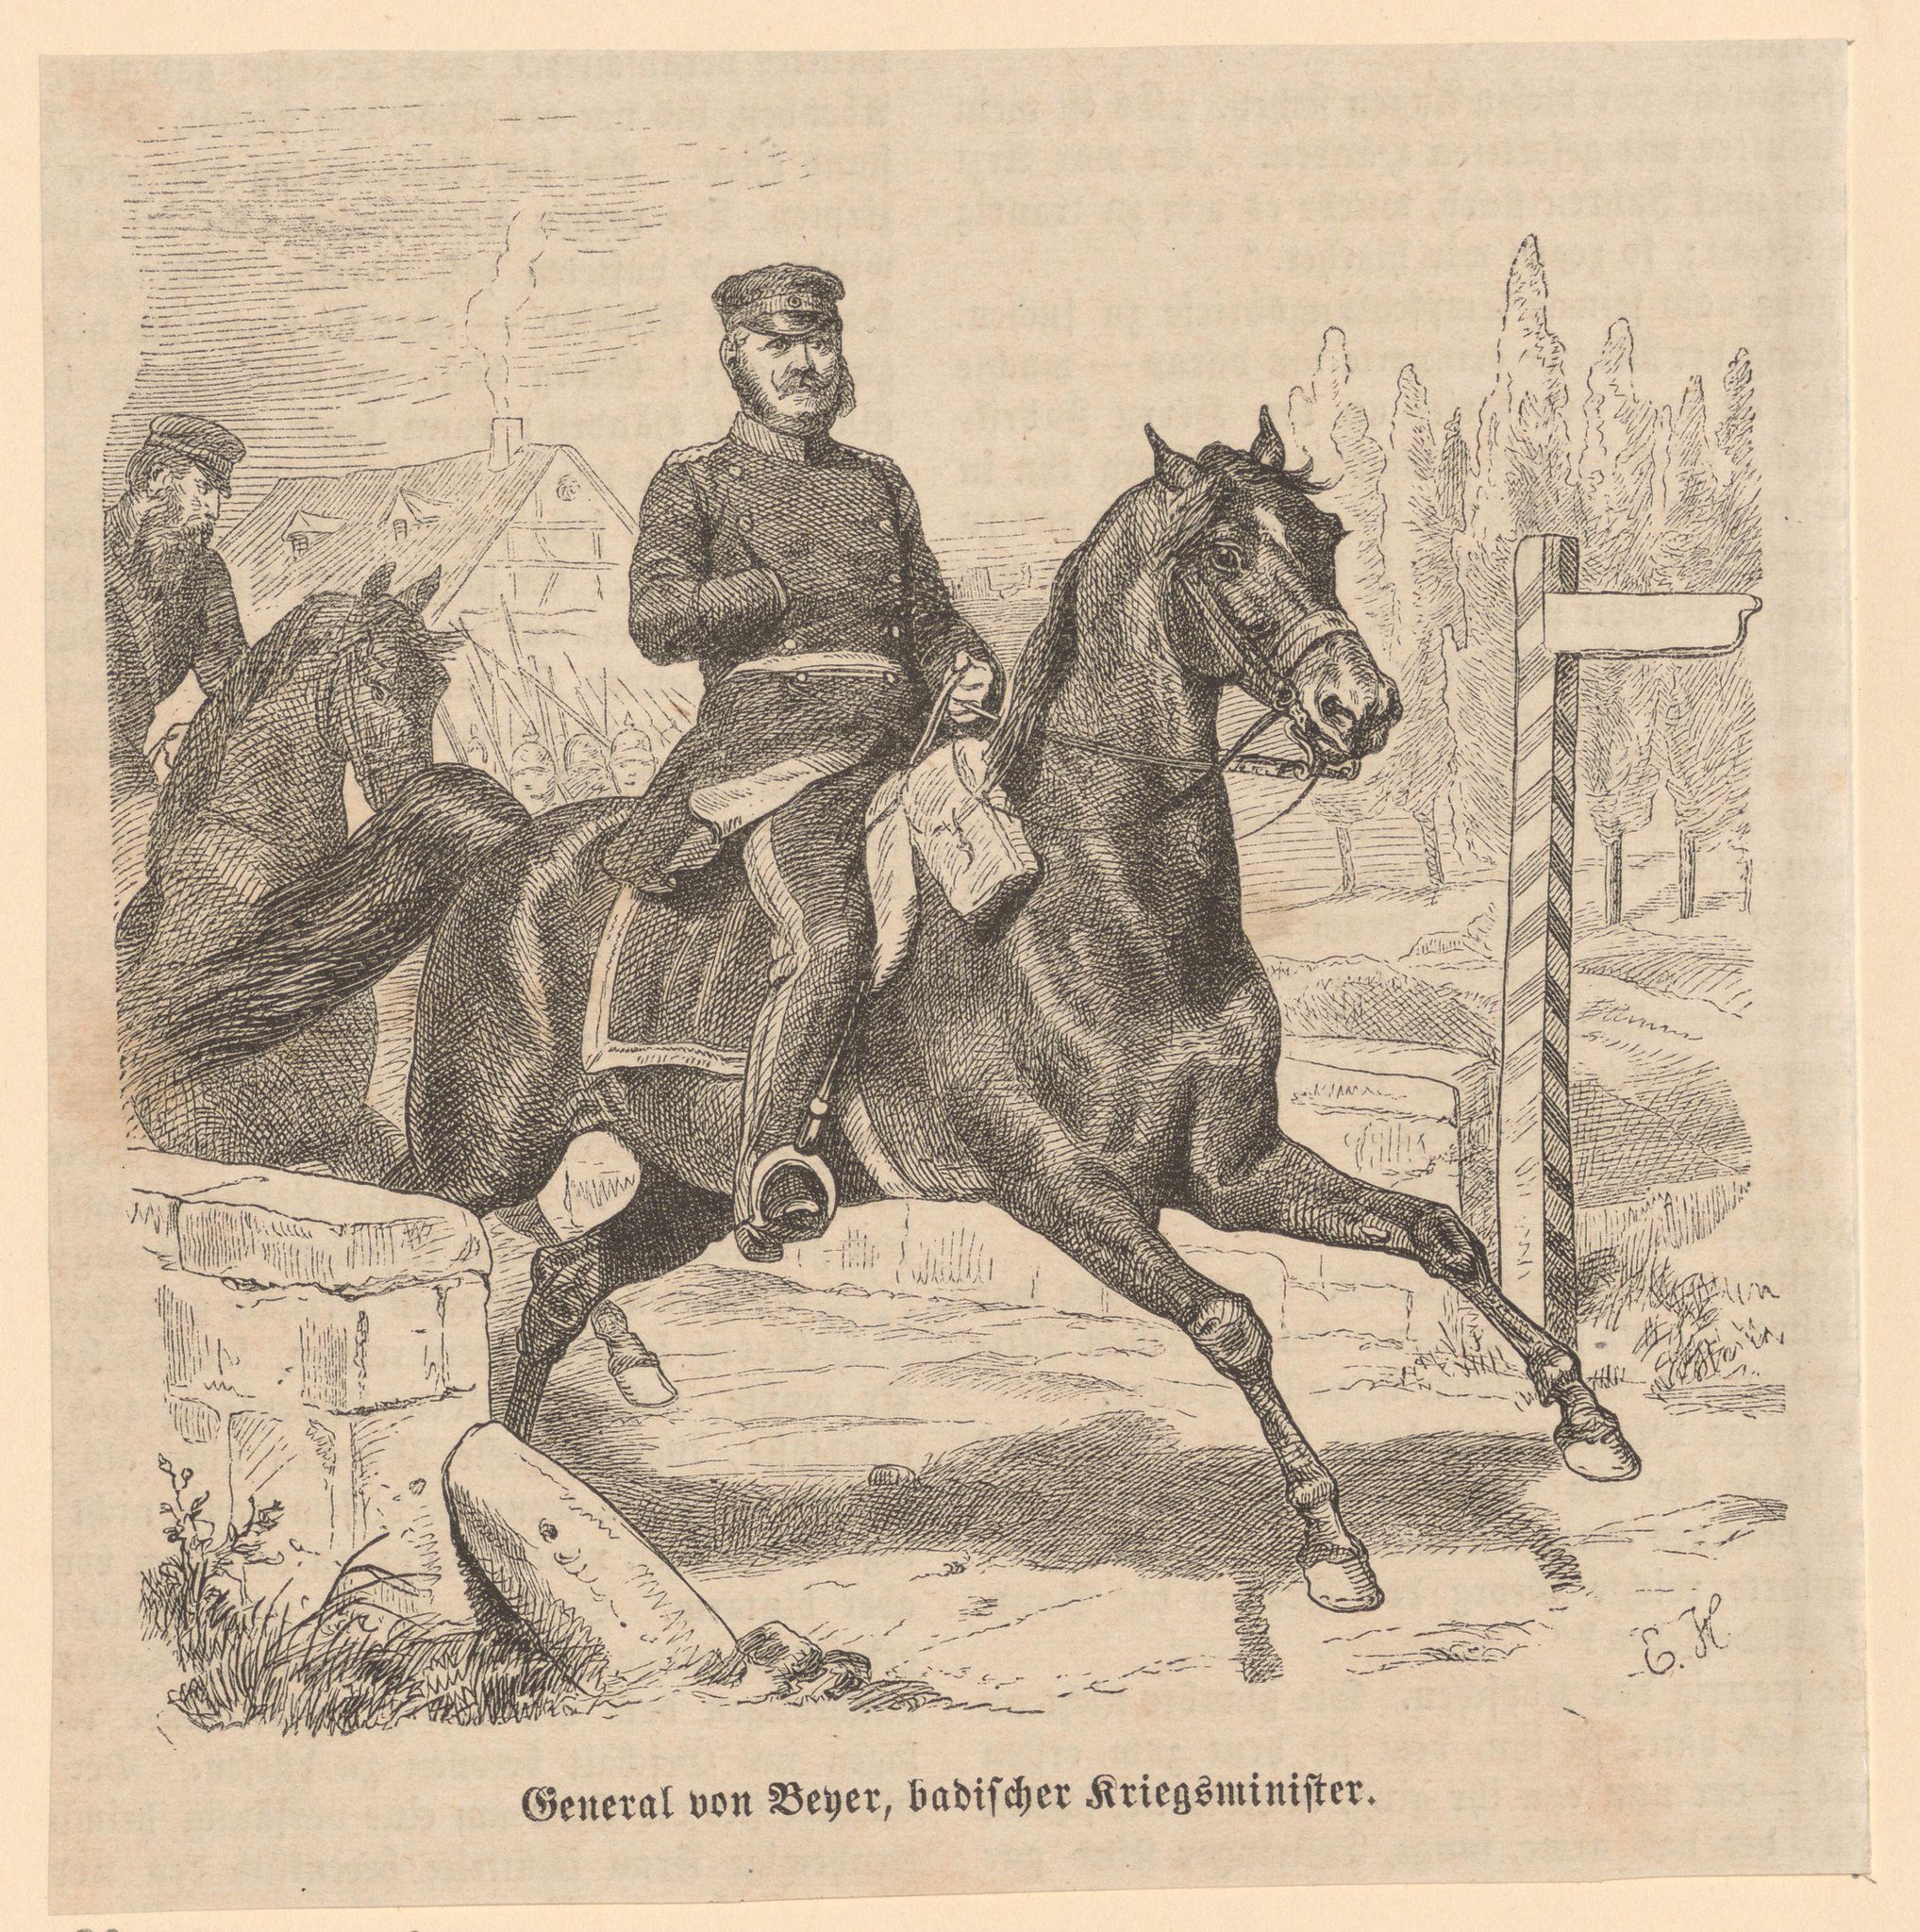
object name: print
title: Ruiterportret van Gustav Friedrich von Beyer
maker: Anonymous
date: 1870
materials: paper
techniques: letterpress printing, engraving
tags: berlin, equestrian state-portrait, historical persons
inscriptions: collector's mark: ‘JVB’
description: Prent uit: Daheim 6 (1870), nr. 47, 20 augustus 1870, p. 740.